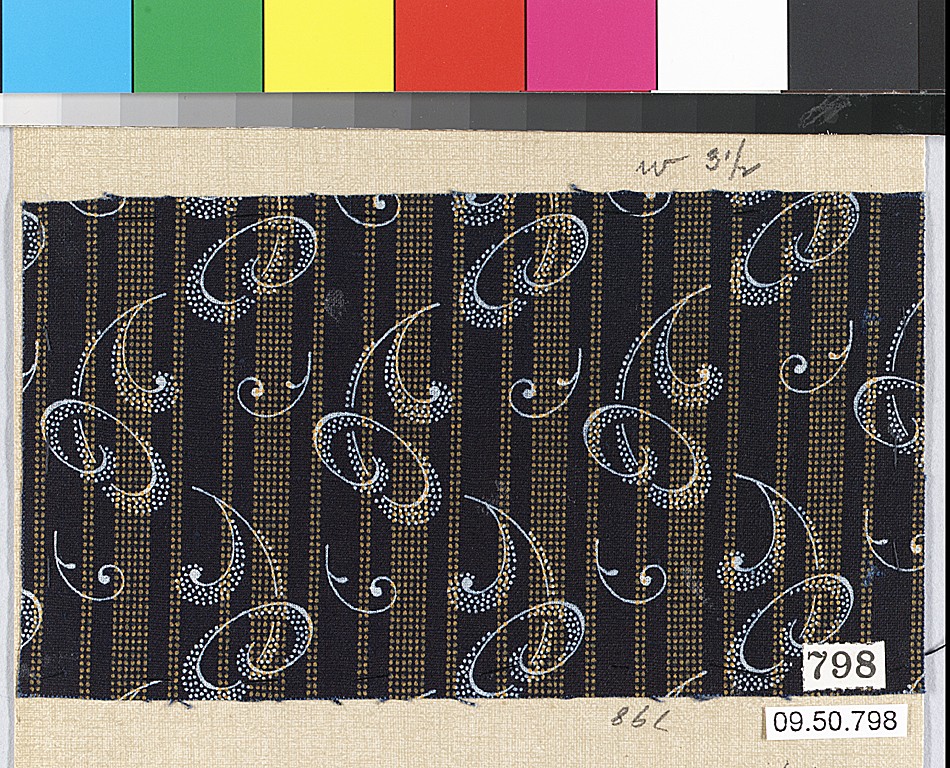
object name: piece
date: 1801-1900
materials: cotton